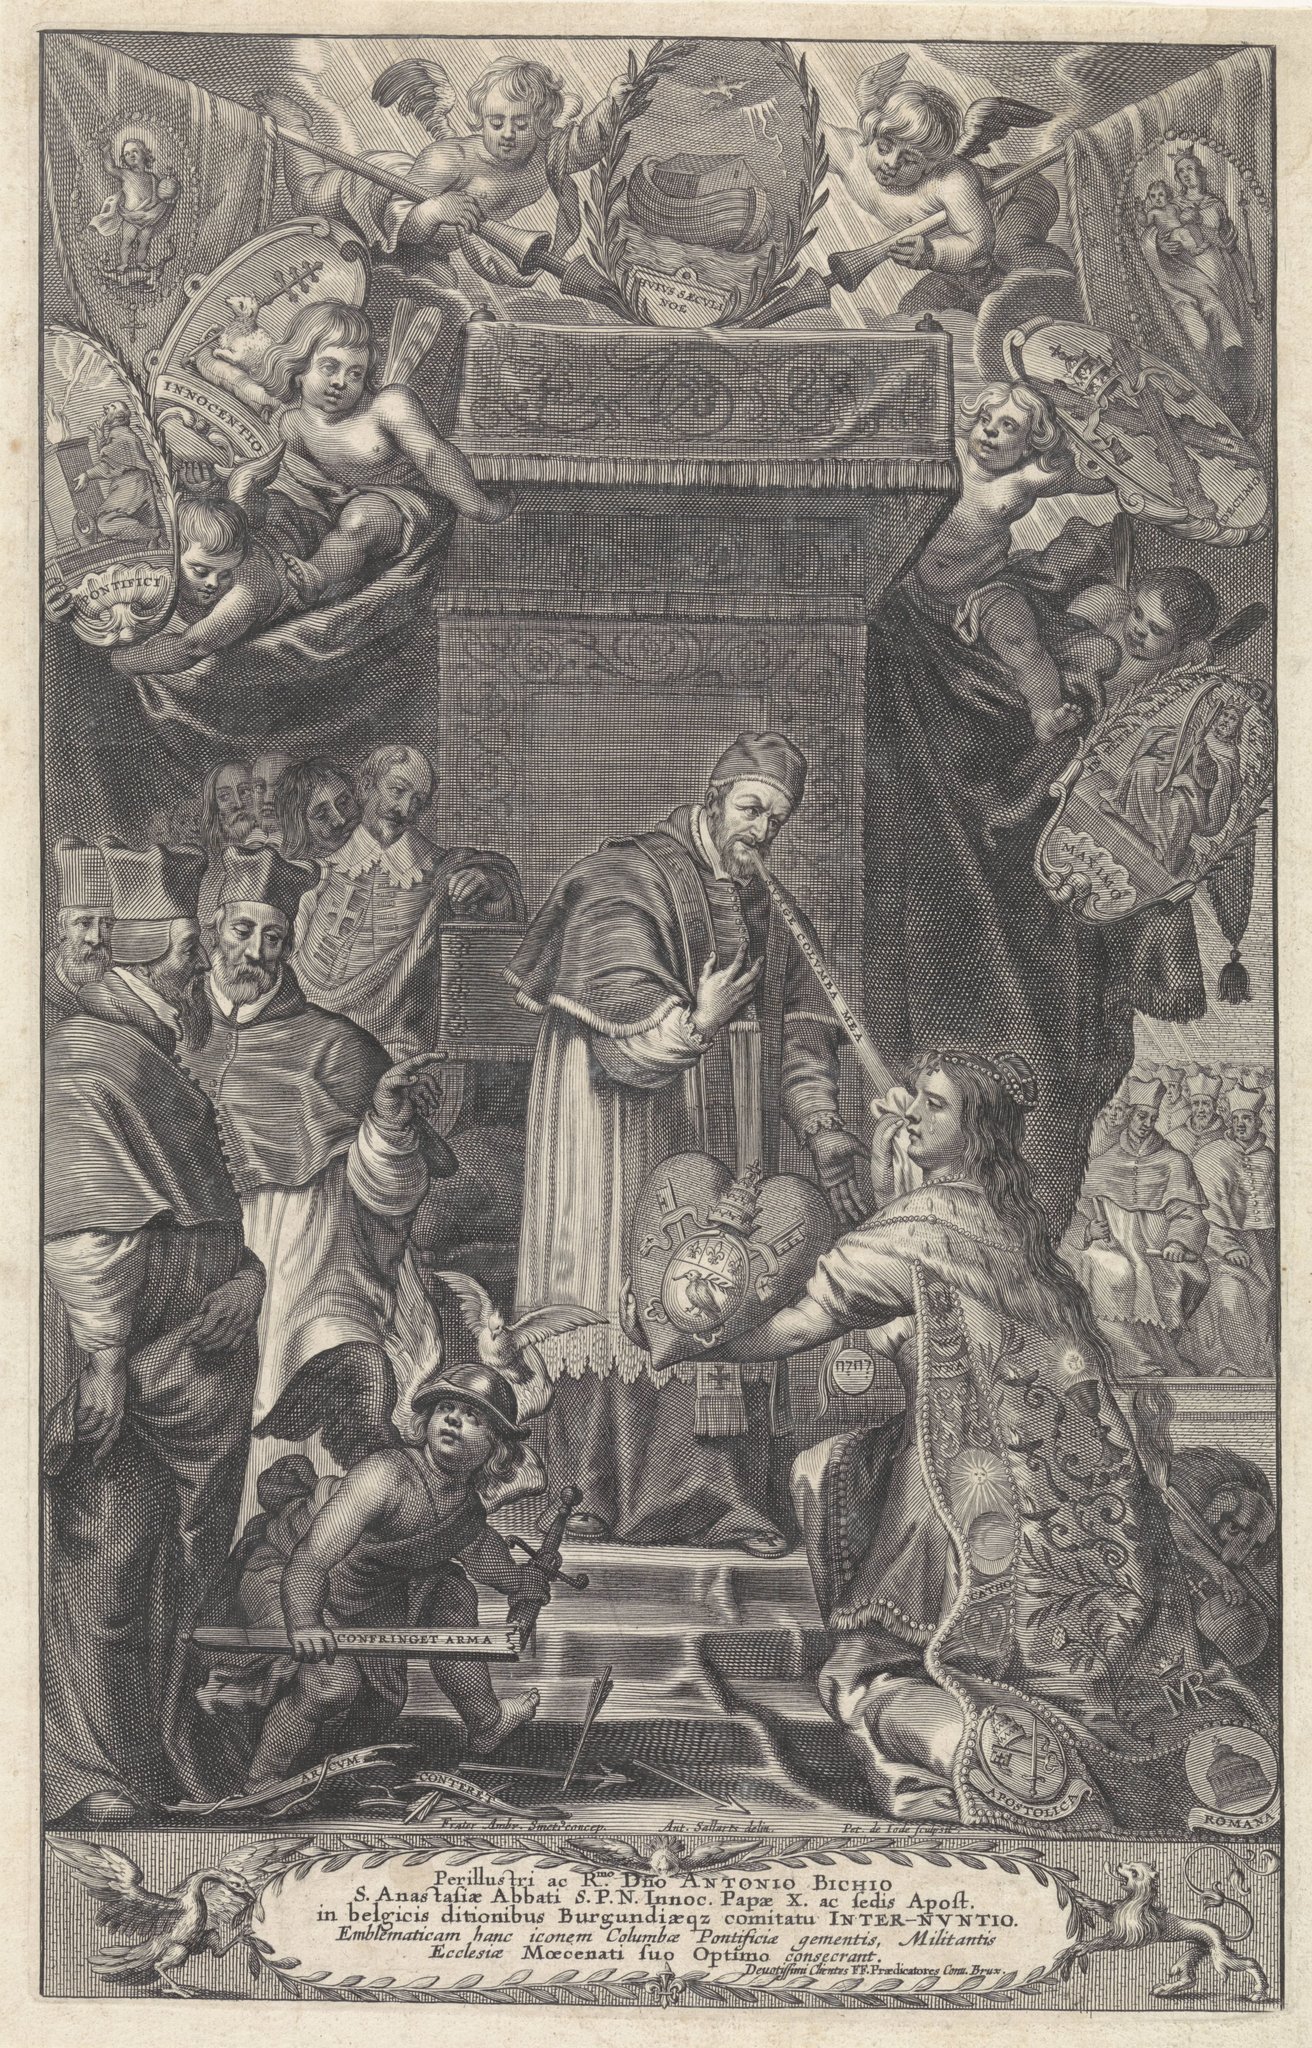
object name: titelblad, titelpagina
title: Titelpagina met paus Innocentius X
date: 1645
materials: paper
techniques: engraving, etching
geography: antwerp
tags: rome, innocentius x, canopy, baldachin, cardinal, pope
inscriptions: collector's mark: Lugt 2228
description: Allegorische voorstelling met in het midden paus Innocentius X onder een baldakijn. Voor hem knielt een huilende, vrouwelijke personificatie met een hartvormig wapenschild in haar handen. Achter haar een hond met een fakkel, spelend met een rijksappel. Rondom hen staan en zitten toekijkende kardinalen. Links op de voorgrond een putto met gebroken wapens. Boven het baldakijn diverse putti met vlaggen en medaillons met bijbelse voorstellingen, waaronder het Lam Gods, de Ark van Noach, Madonna en koning David.